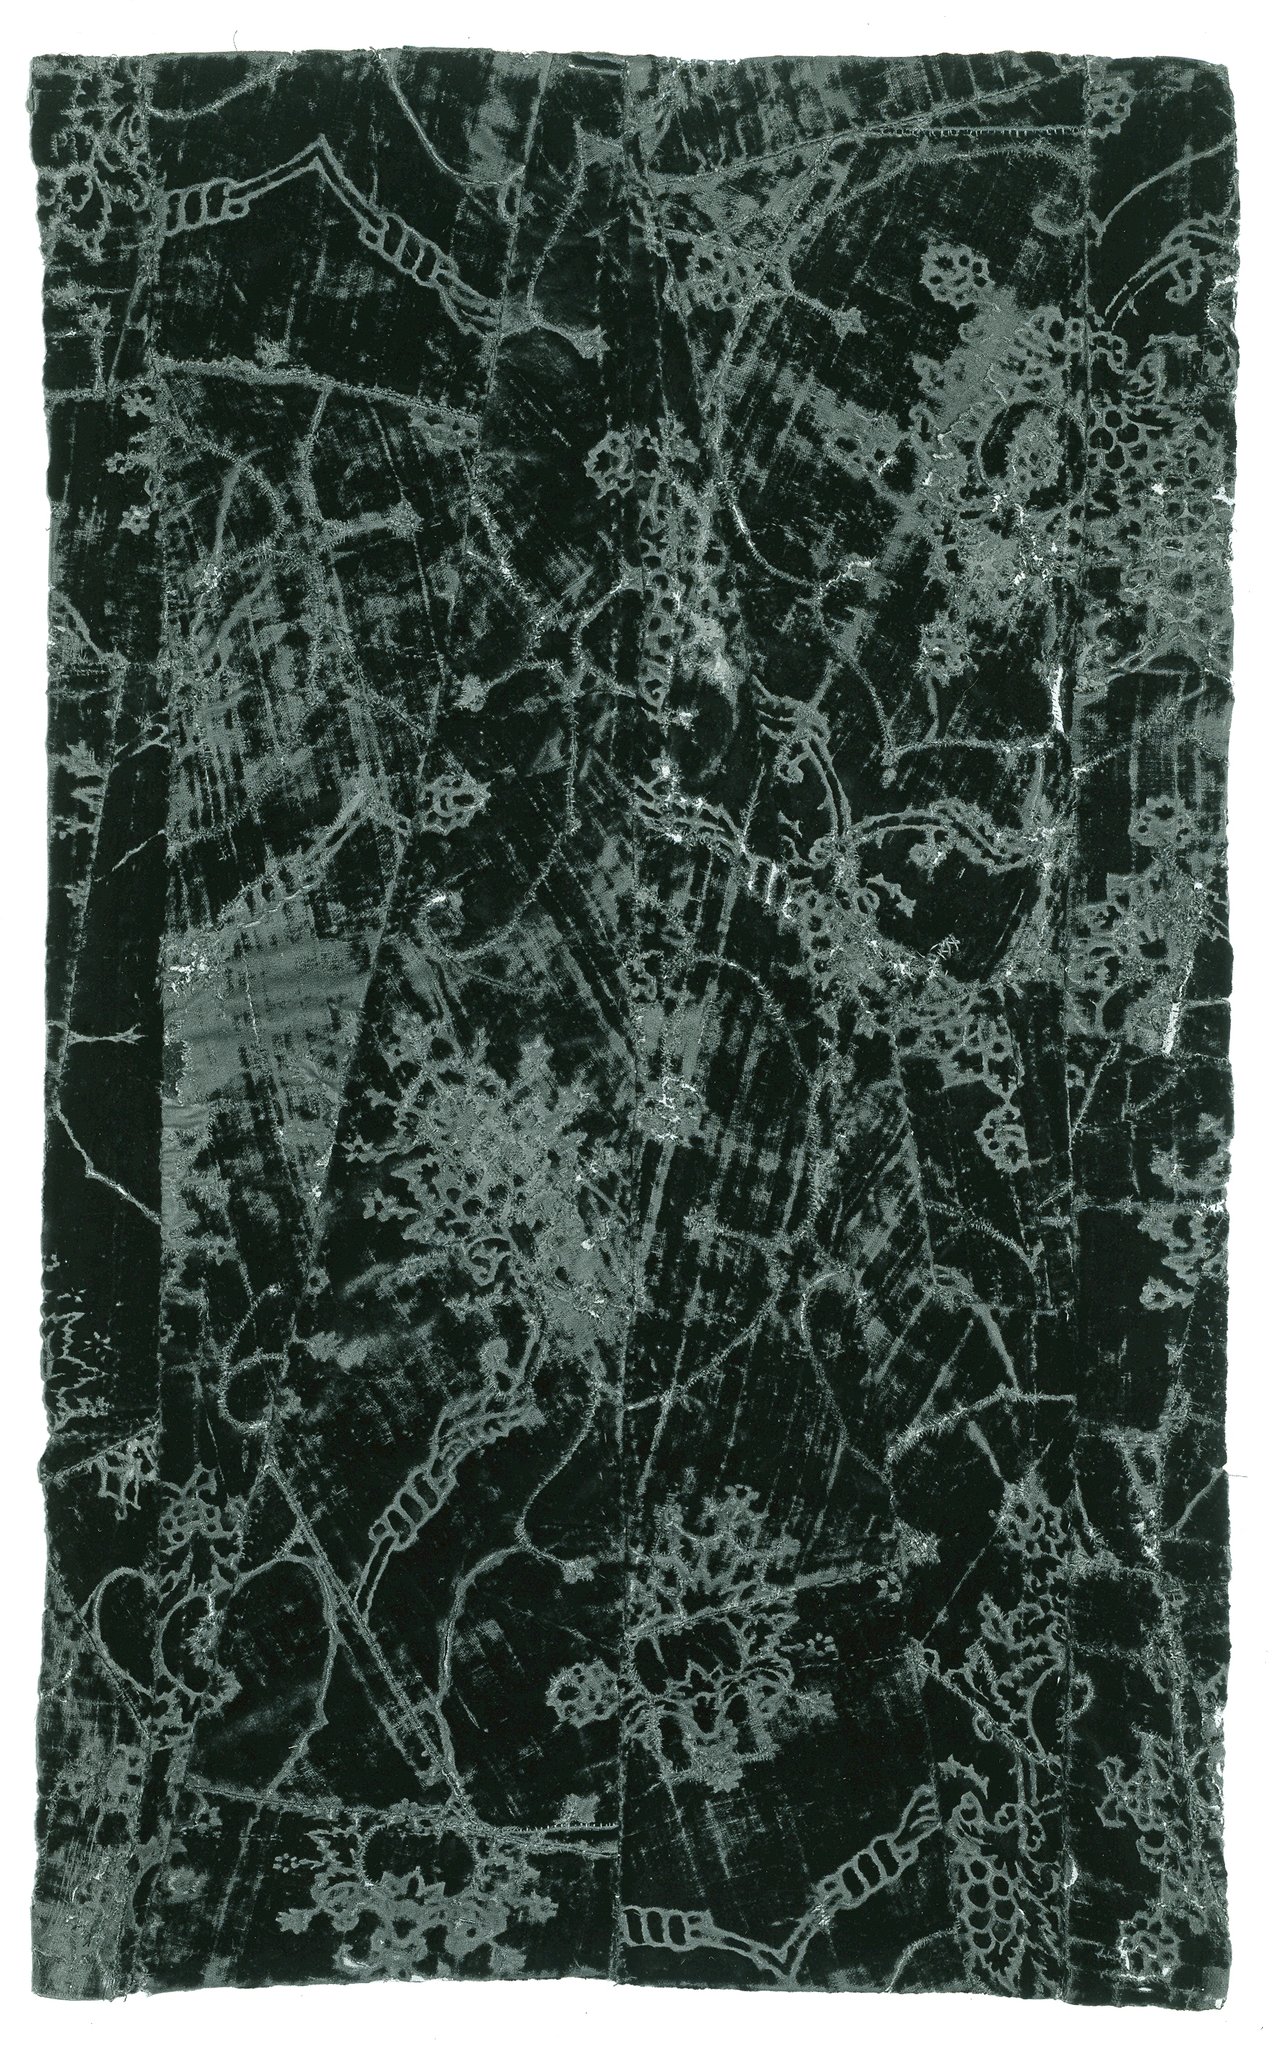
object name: textile panel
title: Panel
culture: italian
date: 1434-1466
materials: cotton, silk